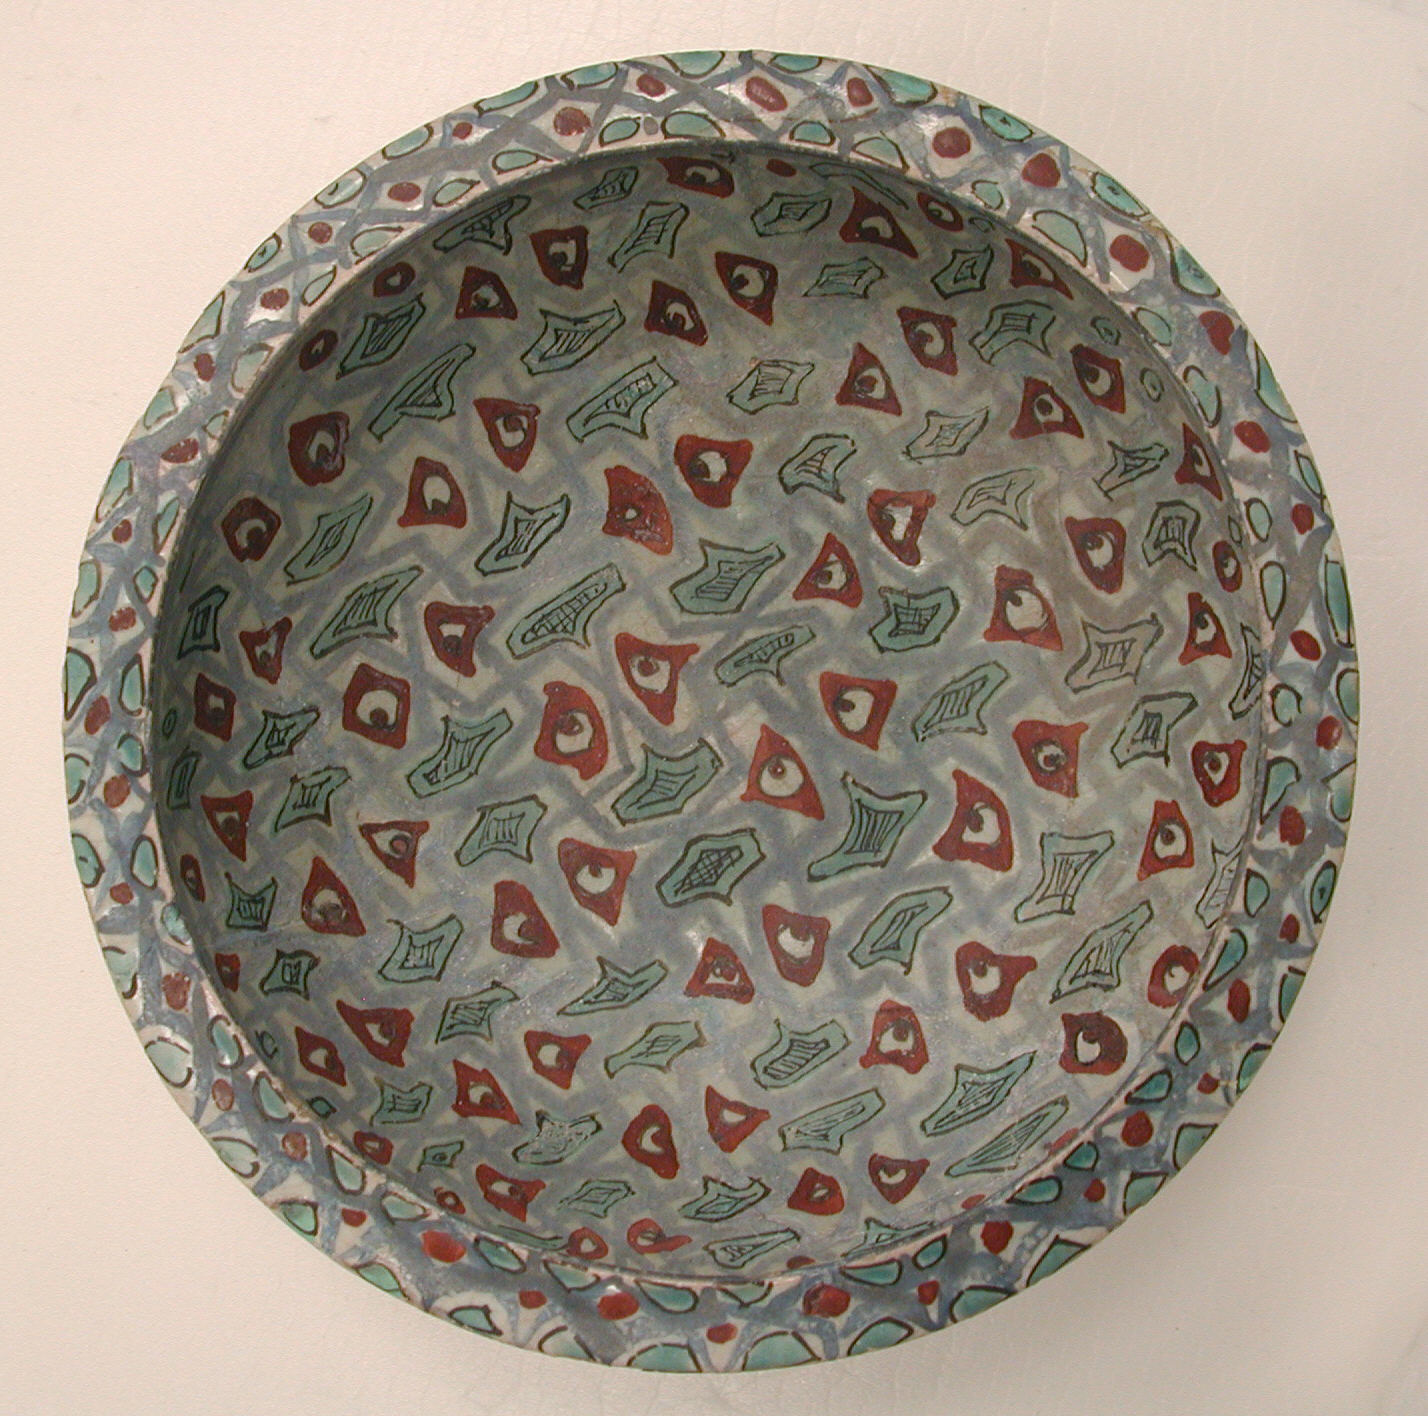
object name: bowl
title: Mina'i Bowl with Abstract Pattern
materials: glaze, stonepaste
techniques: overglaze, painting, polychrome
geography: iran